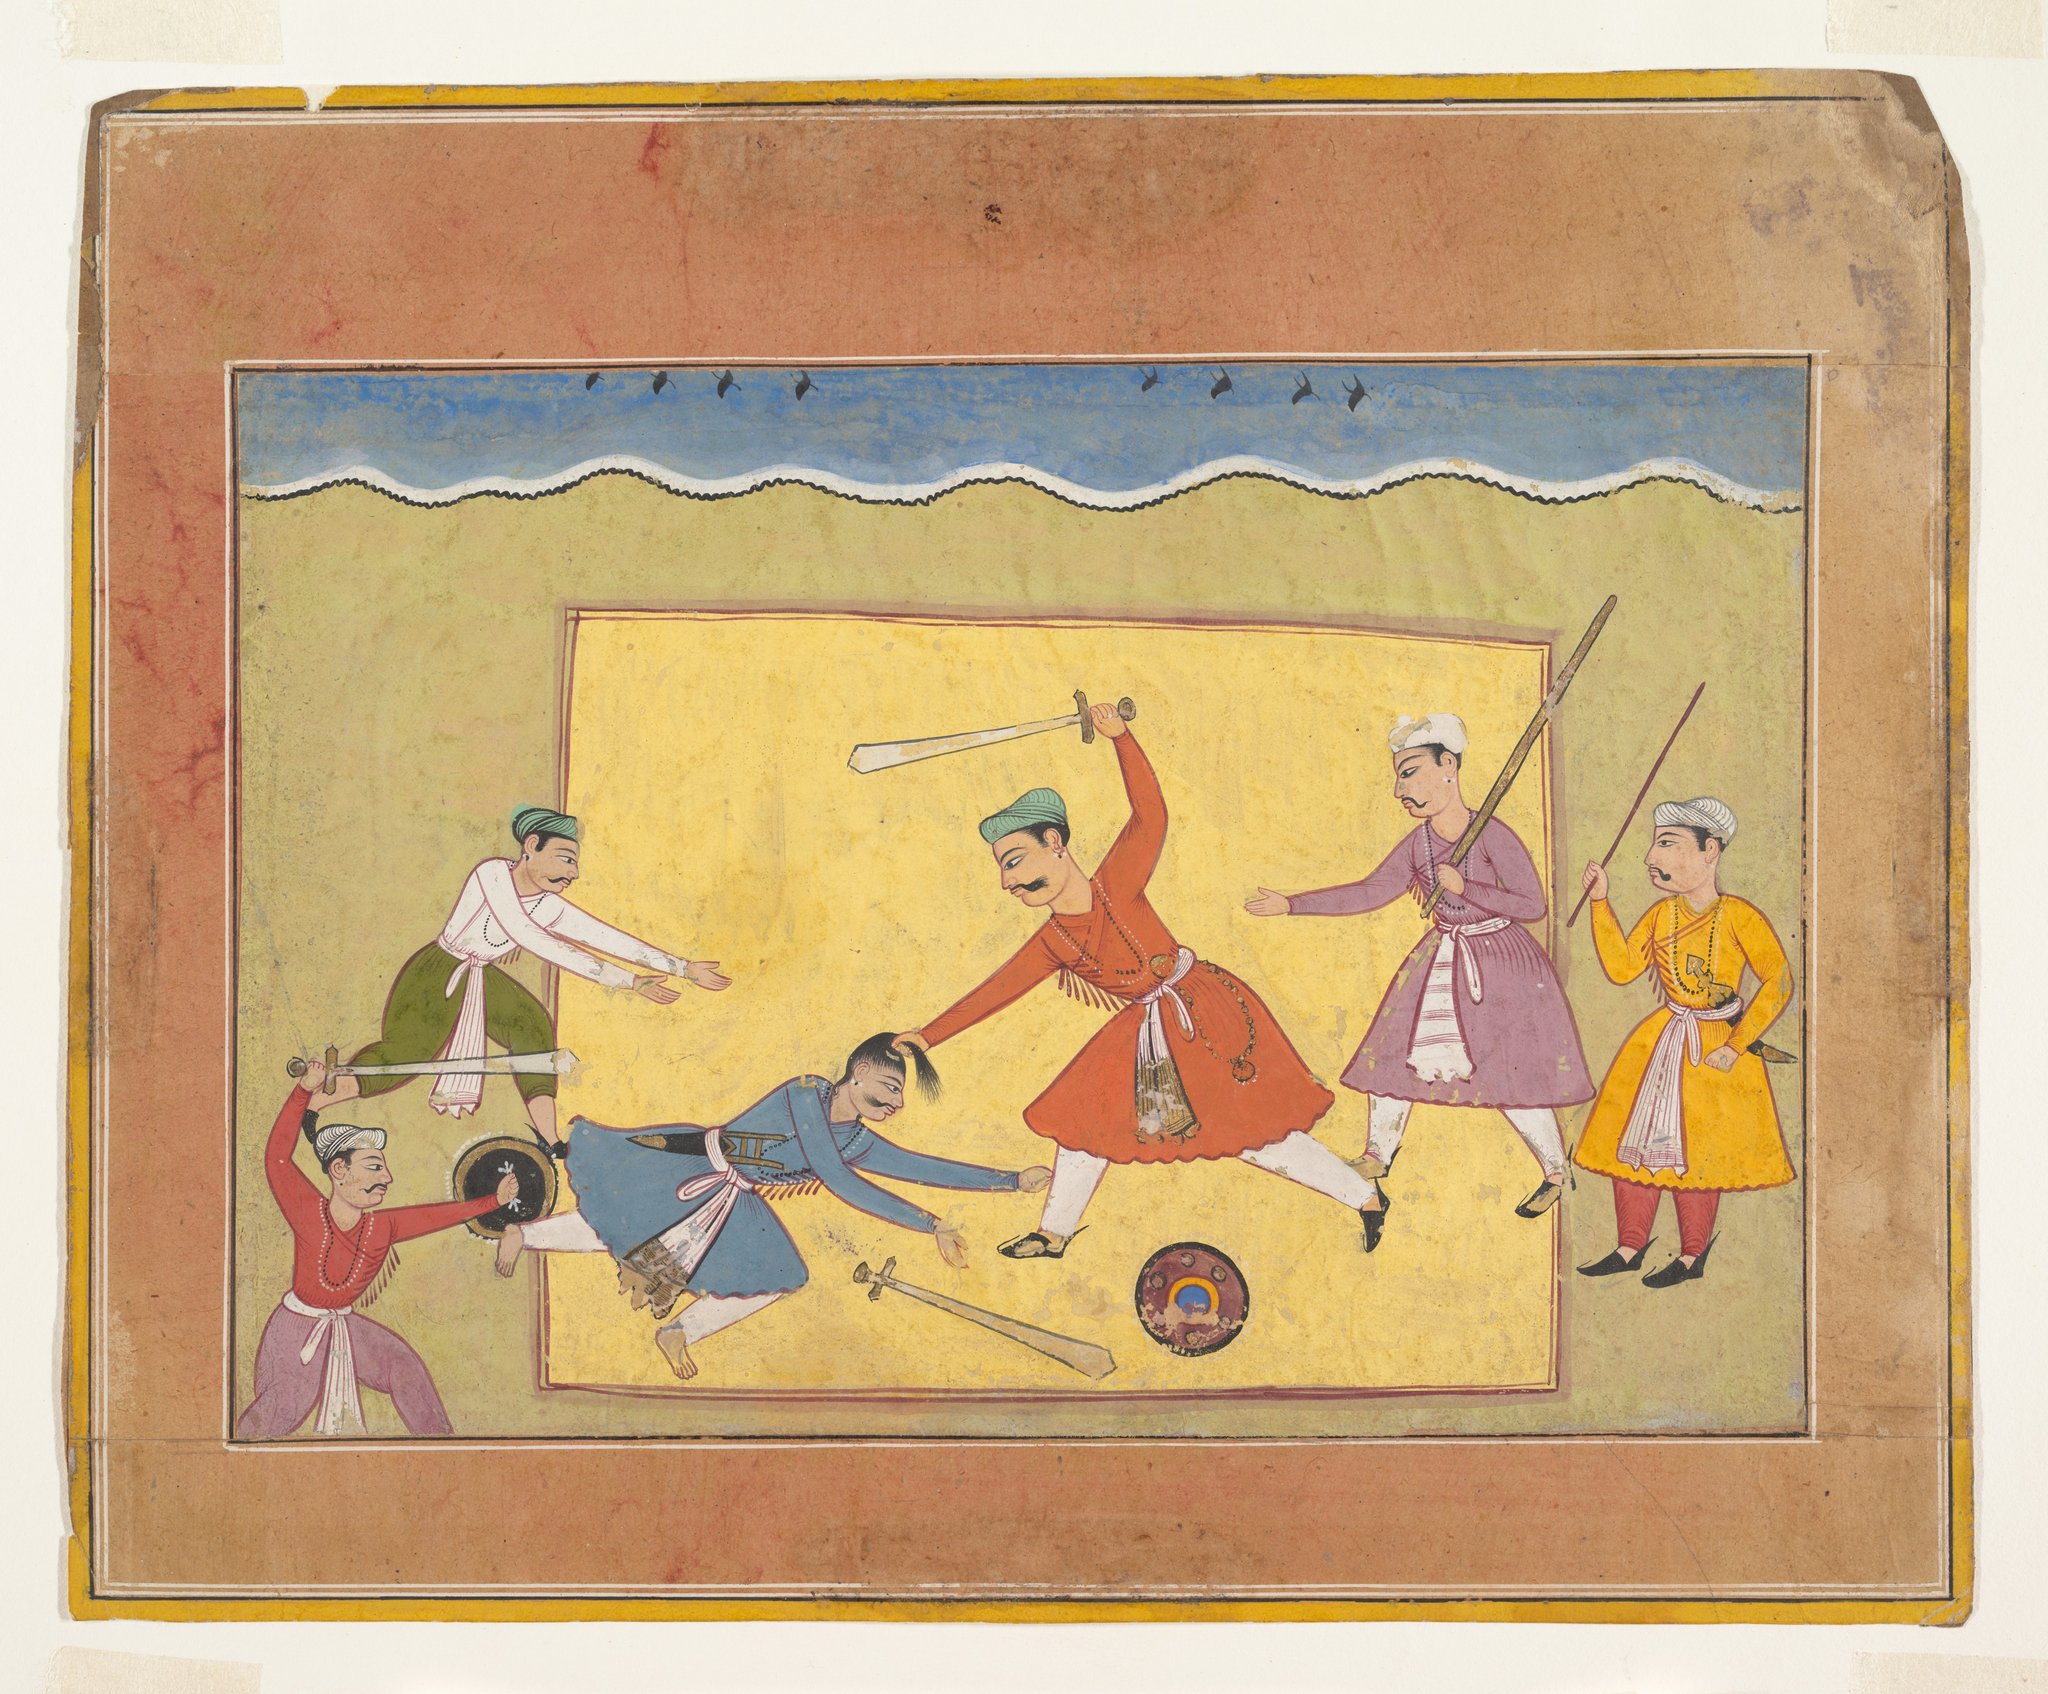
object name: folio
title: Unidentified Page from a Dispersed Bhagavata Purana (Ancient Stories of Lord Vishnu)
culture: indian, rajasthani, bikaner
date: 1610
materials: ink, paper, watercolor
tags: swords,men